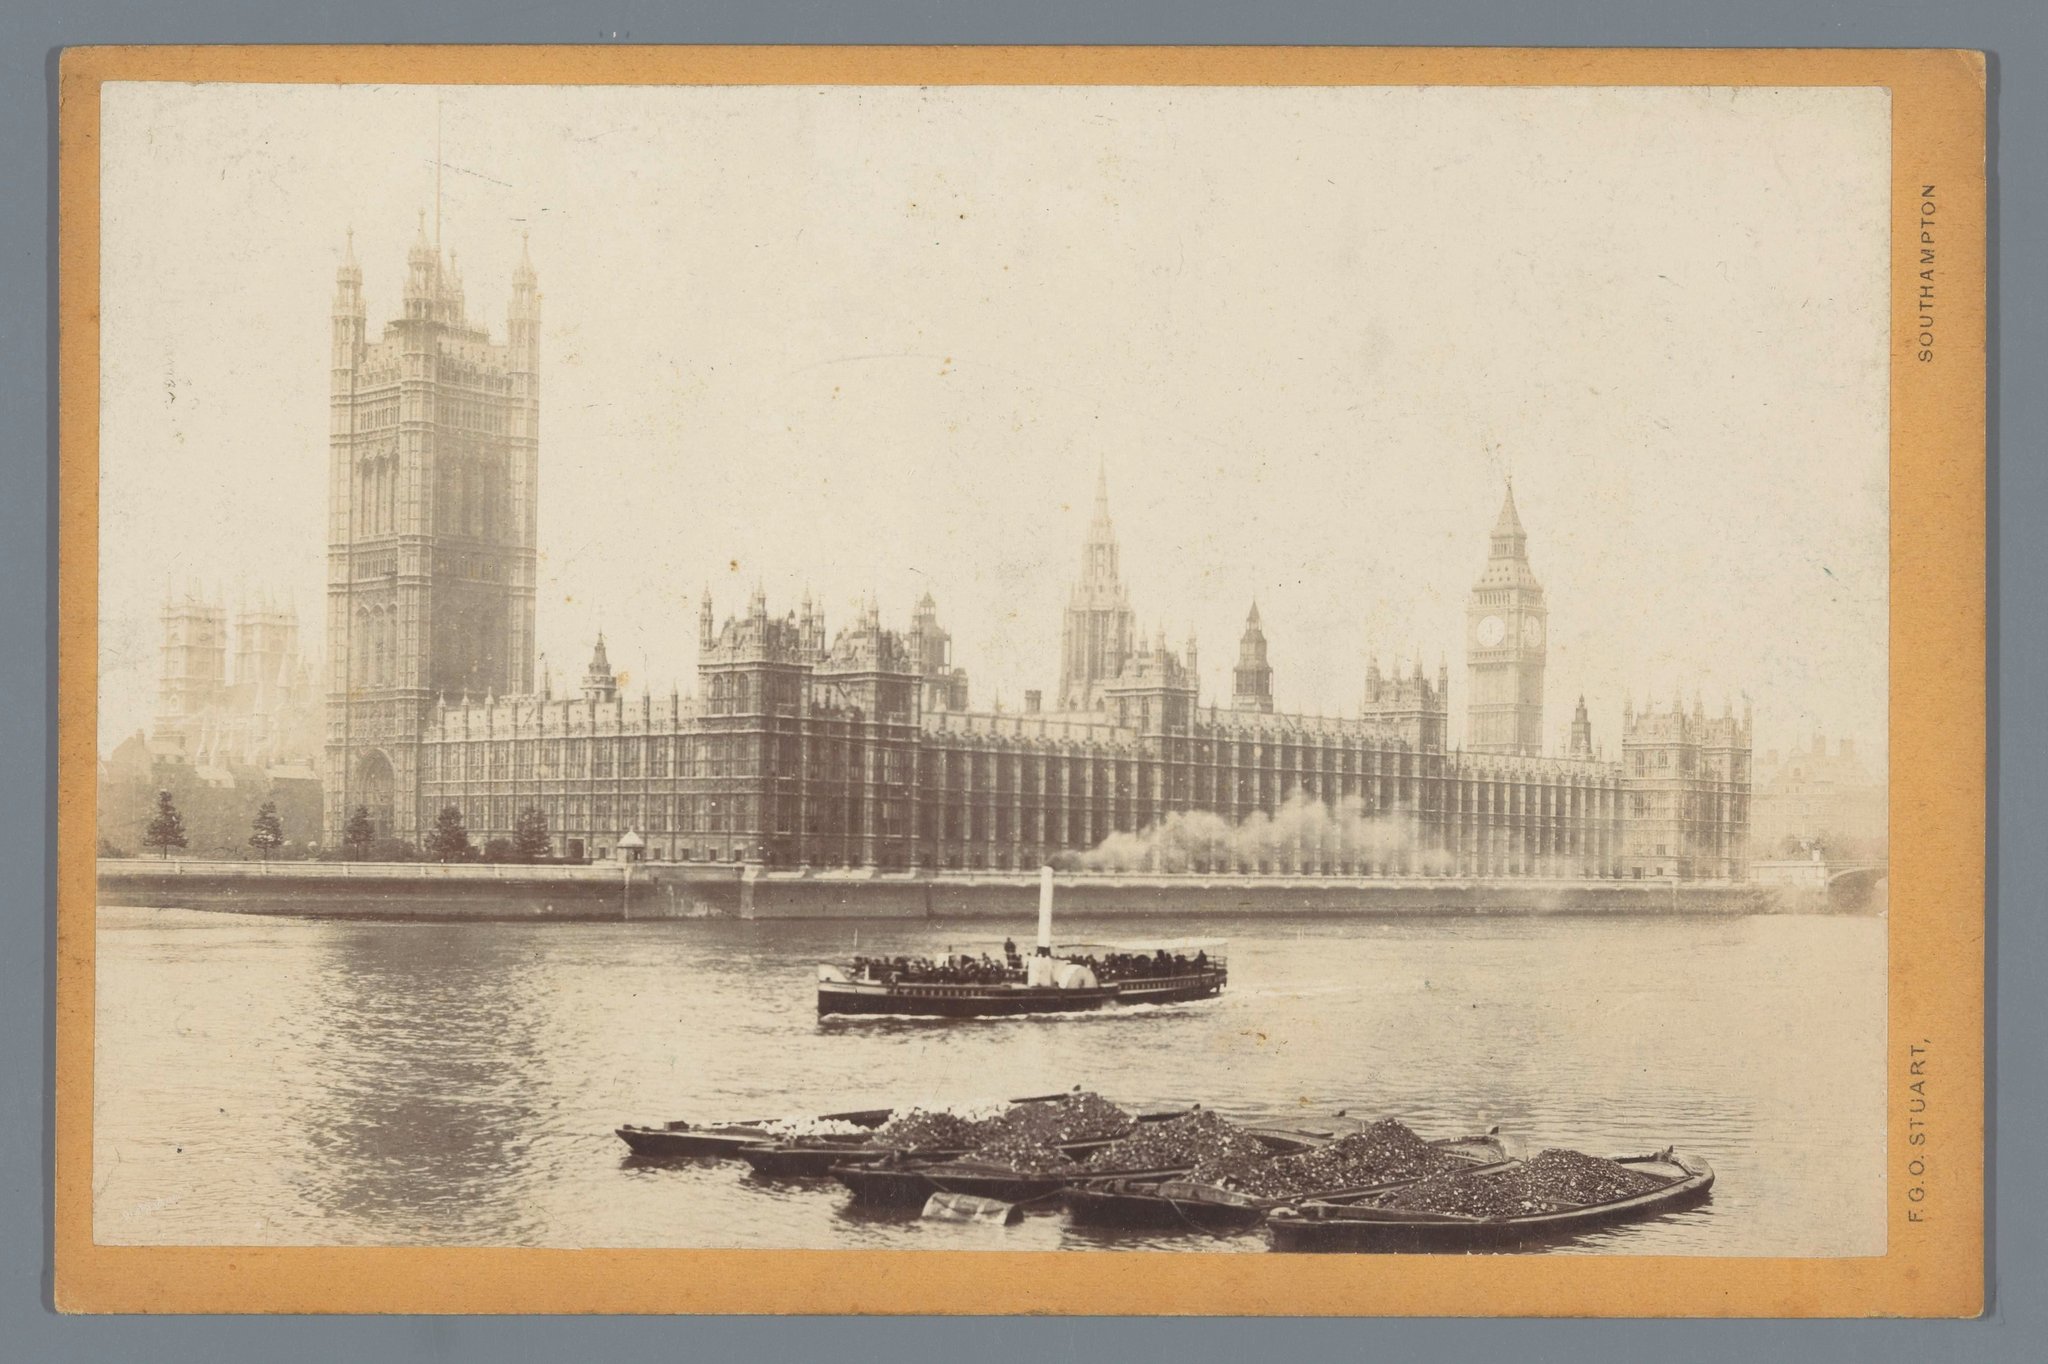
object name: cabinet photograph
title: Gezicht op Westminster Abbey en Houses of Parliament in Londen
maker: francis godolphin osbourne stuart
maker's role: fotograaf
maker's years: 1843-1923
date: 1882-1930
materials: cardboard, photographic support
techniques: gelatin silver print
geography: houses of parliament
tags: lower house, parliament, chamber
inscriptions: inscription: ‘Cromwell road Southampton./ Photographed by/ F.G.O. Stuart/ Portrait&Landscape Photographer/ late/ 4, Hamlet Terrace,/ Upper Norwood, S.E./ and/ 75 St. Paul's Churchyard E.C.’, annotation: ‘3 Aug '95./ The Houses of Parliament/ London’, name: ‘Arthur G. Atterbury’